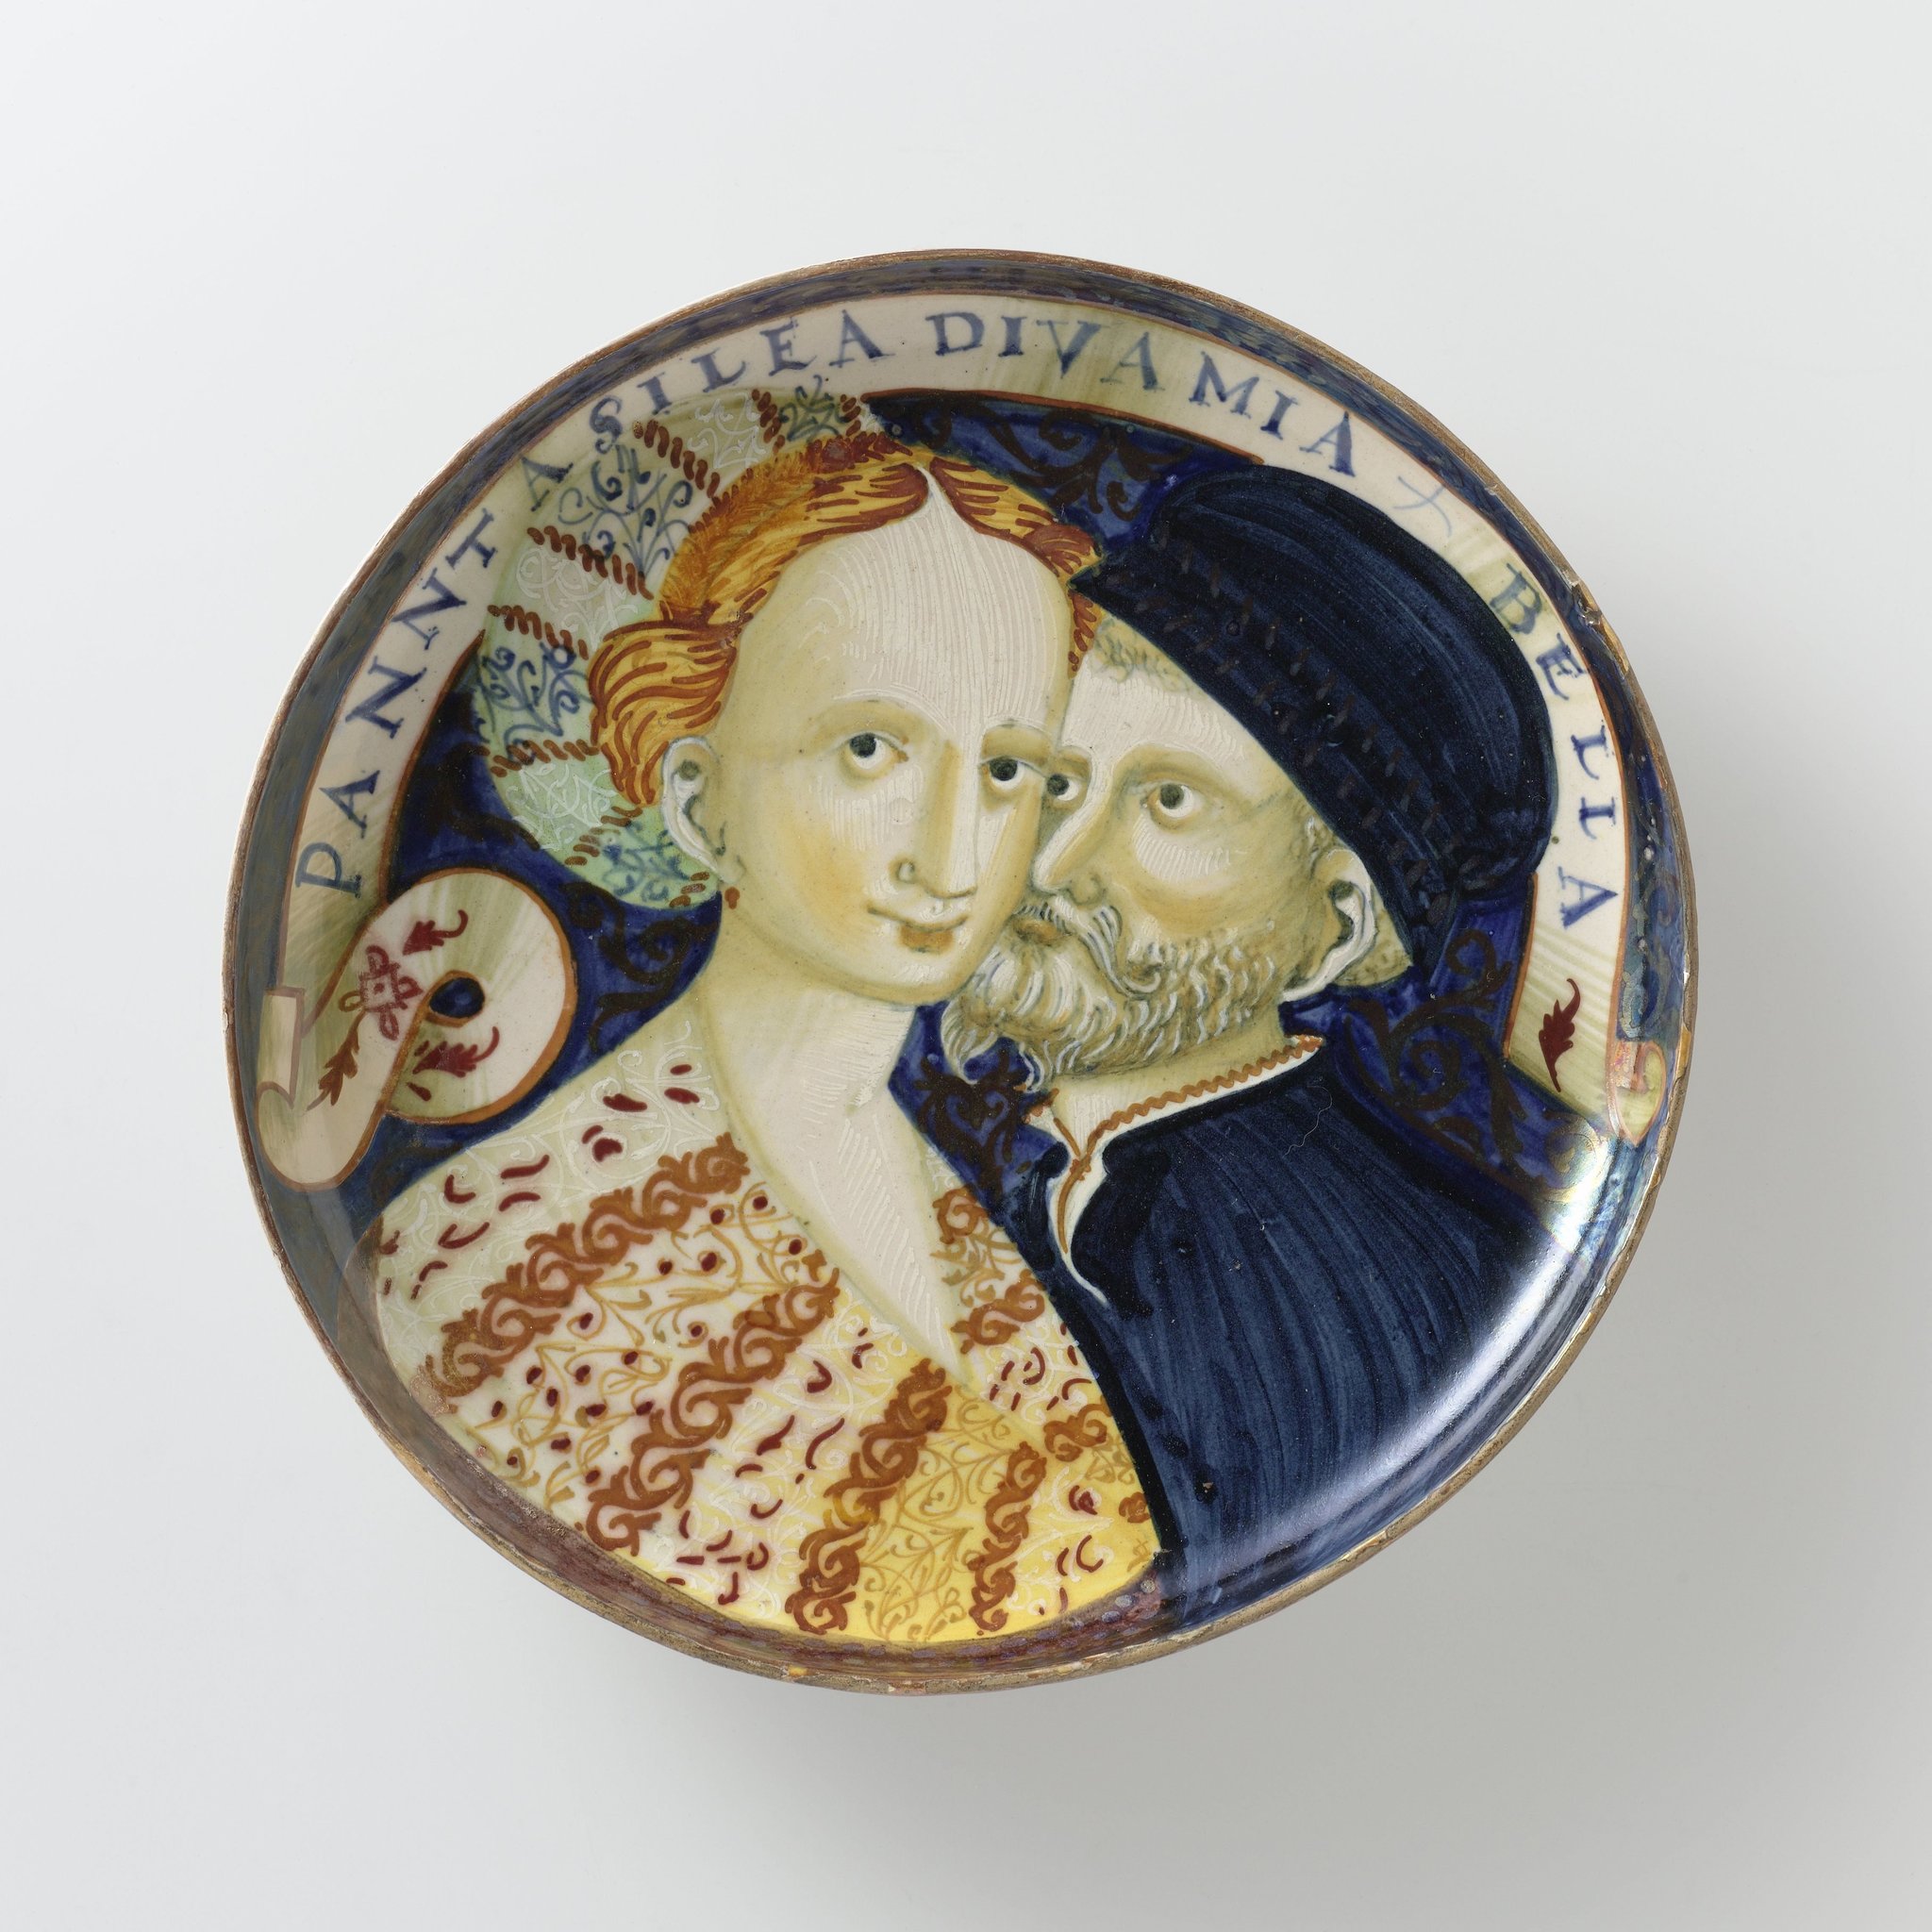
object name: dish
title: Dish with a man and a woman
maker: Anonymous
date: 1530-1540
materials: earthenware, glaze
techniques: maiolica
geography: urbino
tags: couple of lovers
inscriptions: inscription: ‘PANNTASILEA DIVA MIA BELLA.’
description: Schaal op voet van veelkleurig beschilderde majolica. Op blauwe grond beschilderd met de borstbeelden van een jonge vrouw en een man met baard. Beide dragen een muts. De kleding van de vrouw is rijk versierd. Langs de bovenrand loopt een banderolle met opschrift "PANNTASILEA DIVA MIA BELLA" (Penthesileia, mijn goddelijke schone). De schaal is voorzien van extra decoratie in metaal-luster in goud en rood.